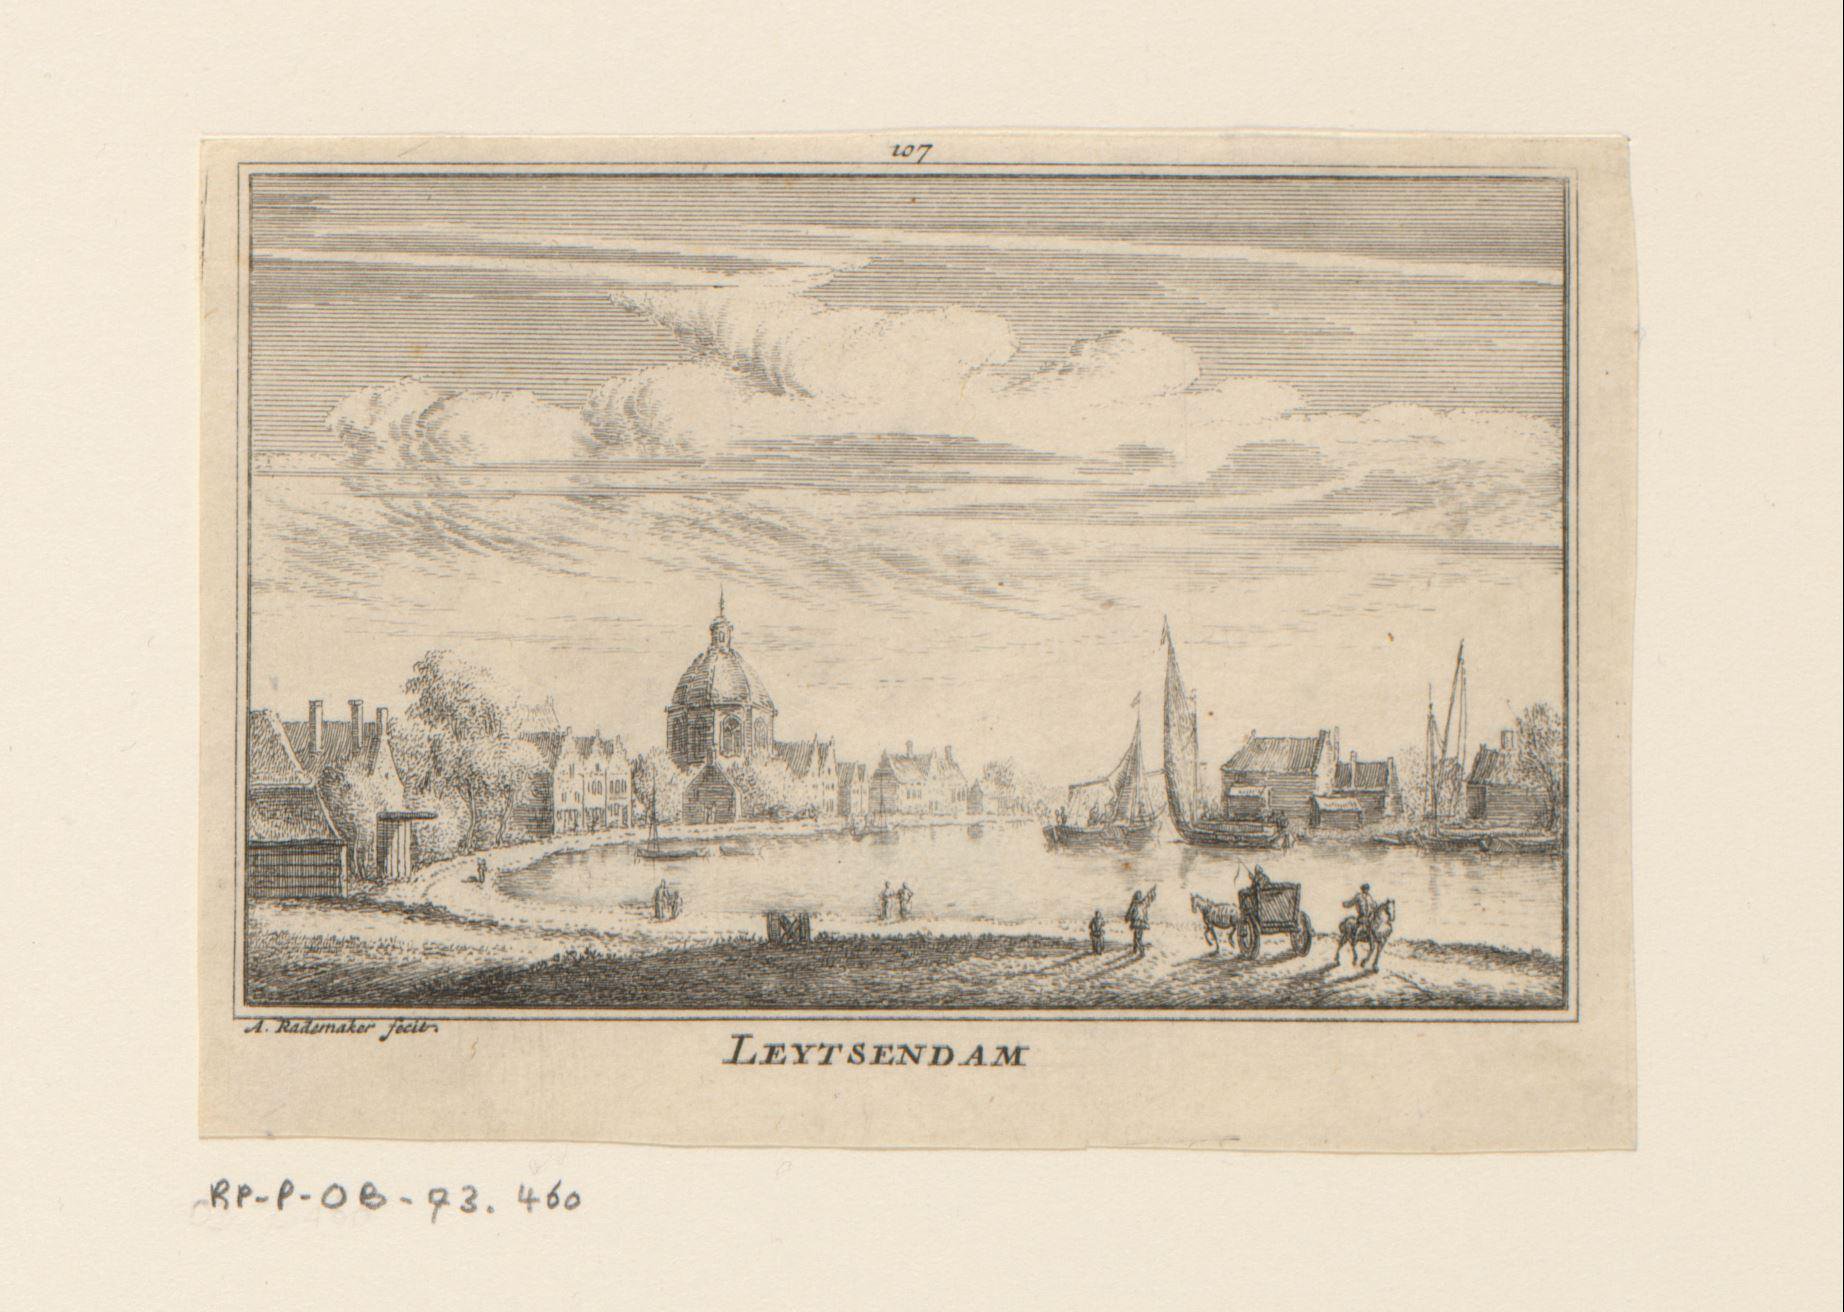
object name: print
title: Leytsendam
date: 1727-1733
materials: paper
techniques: etching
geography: amsterdam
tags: prospect of village, silhouette of village, sailing-ship, sailing-boat, church (exterior)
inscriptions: collector's mark: Lugt 2228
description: Illustratie uit: Abraham Rademaker, Matthaeus Brouërius van Niedek, Isaac Le Long, Kabinet van Nederlandsche en Kleefsche outheden en (...) voorname stads- en landgebouwen, Willem Barents en Antoni Schoonenburg: Amsterdam, 1727-1733, ill. nr. 107.